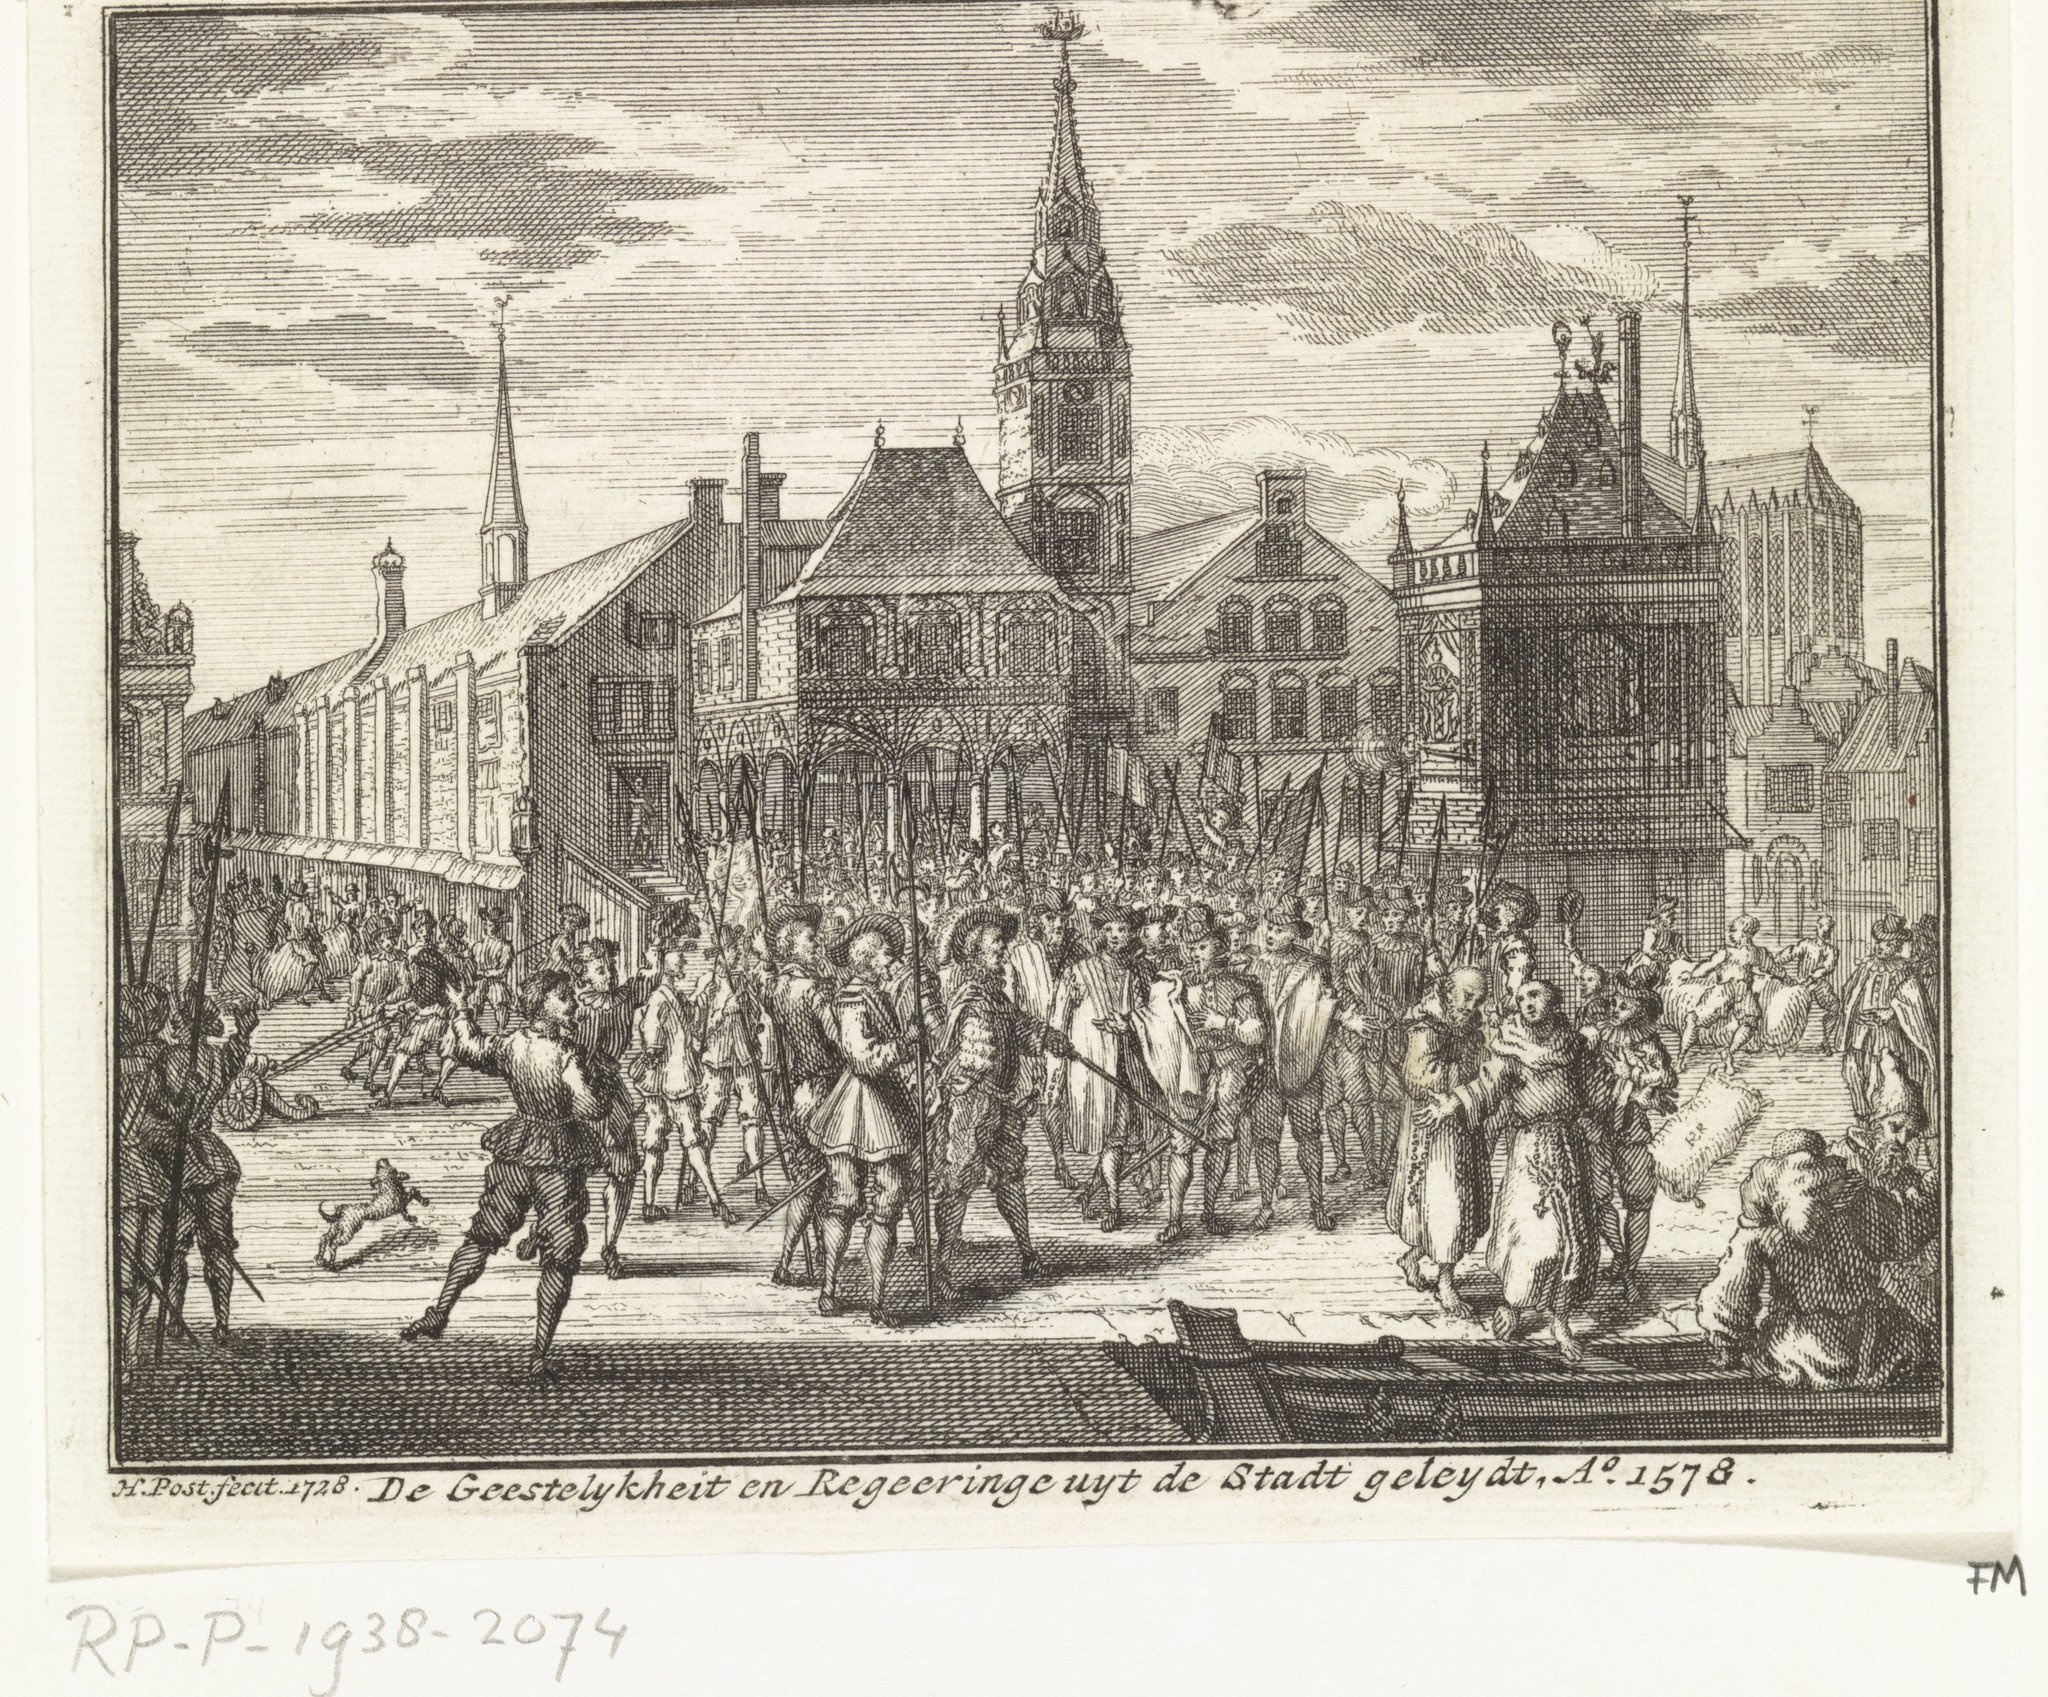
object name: print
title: Alteratie van Amsterdam, 26 mei 1578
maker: hendrik post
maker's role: draughtsman, print maker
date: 1728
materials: paper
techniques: engraving, etching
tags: dam, stadhuis van amsterdam (14e eeuw-1652), alteratie van amsterdam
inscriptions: collector's mark: Lugt 2166, collector's mark: Lugt 2760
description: Alteratie van Amsterdam, 26 mei 1578. Het Spaansgezinde stadsbestuur en de roomse geestelijkheid worden gedwongen te vertrekken, op de kade bij de Dam stappen zij in gereed staande boten.